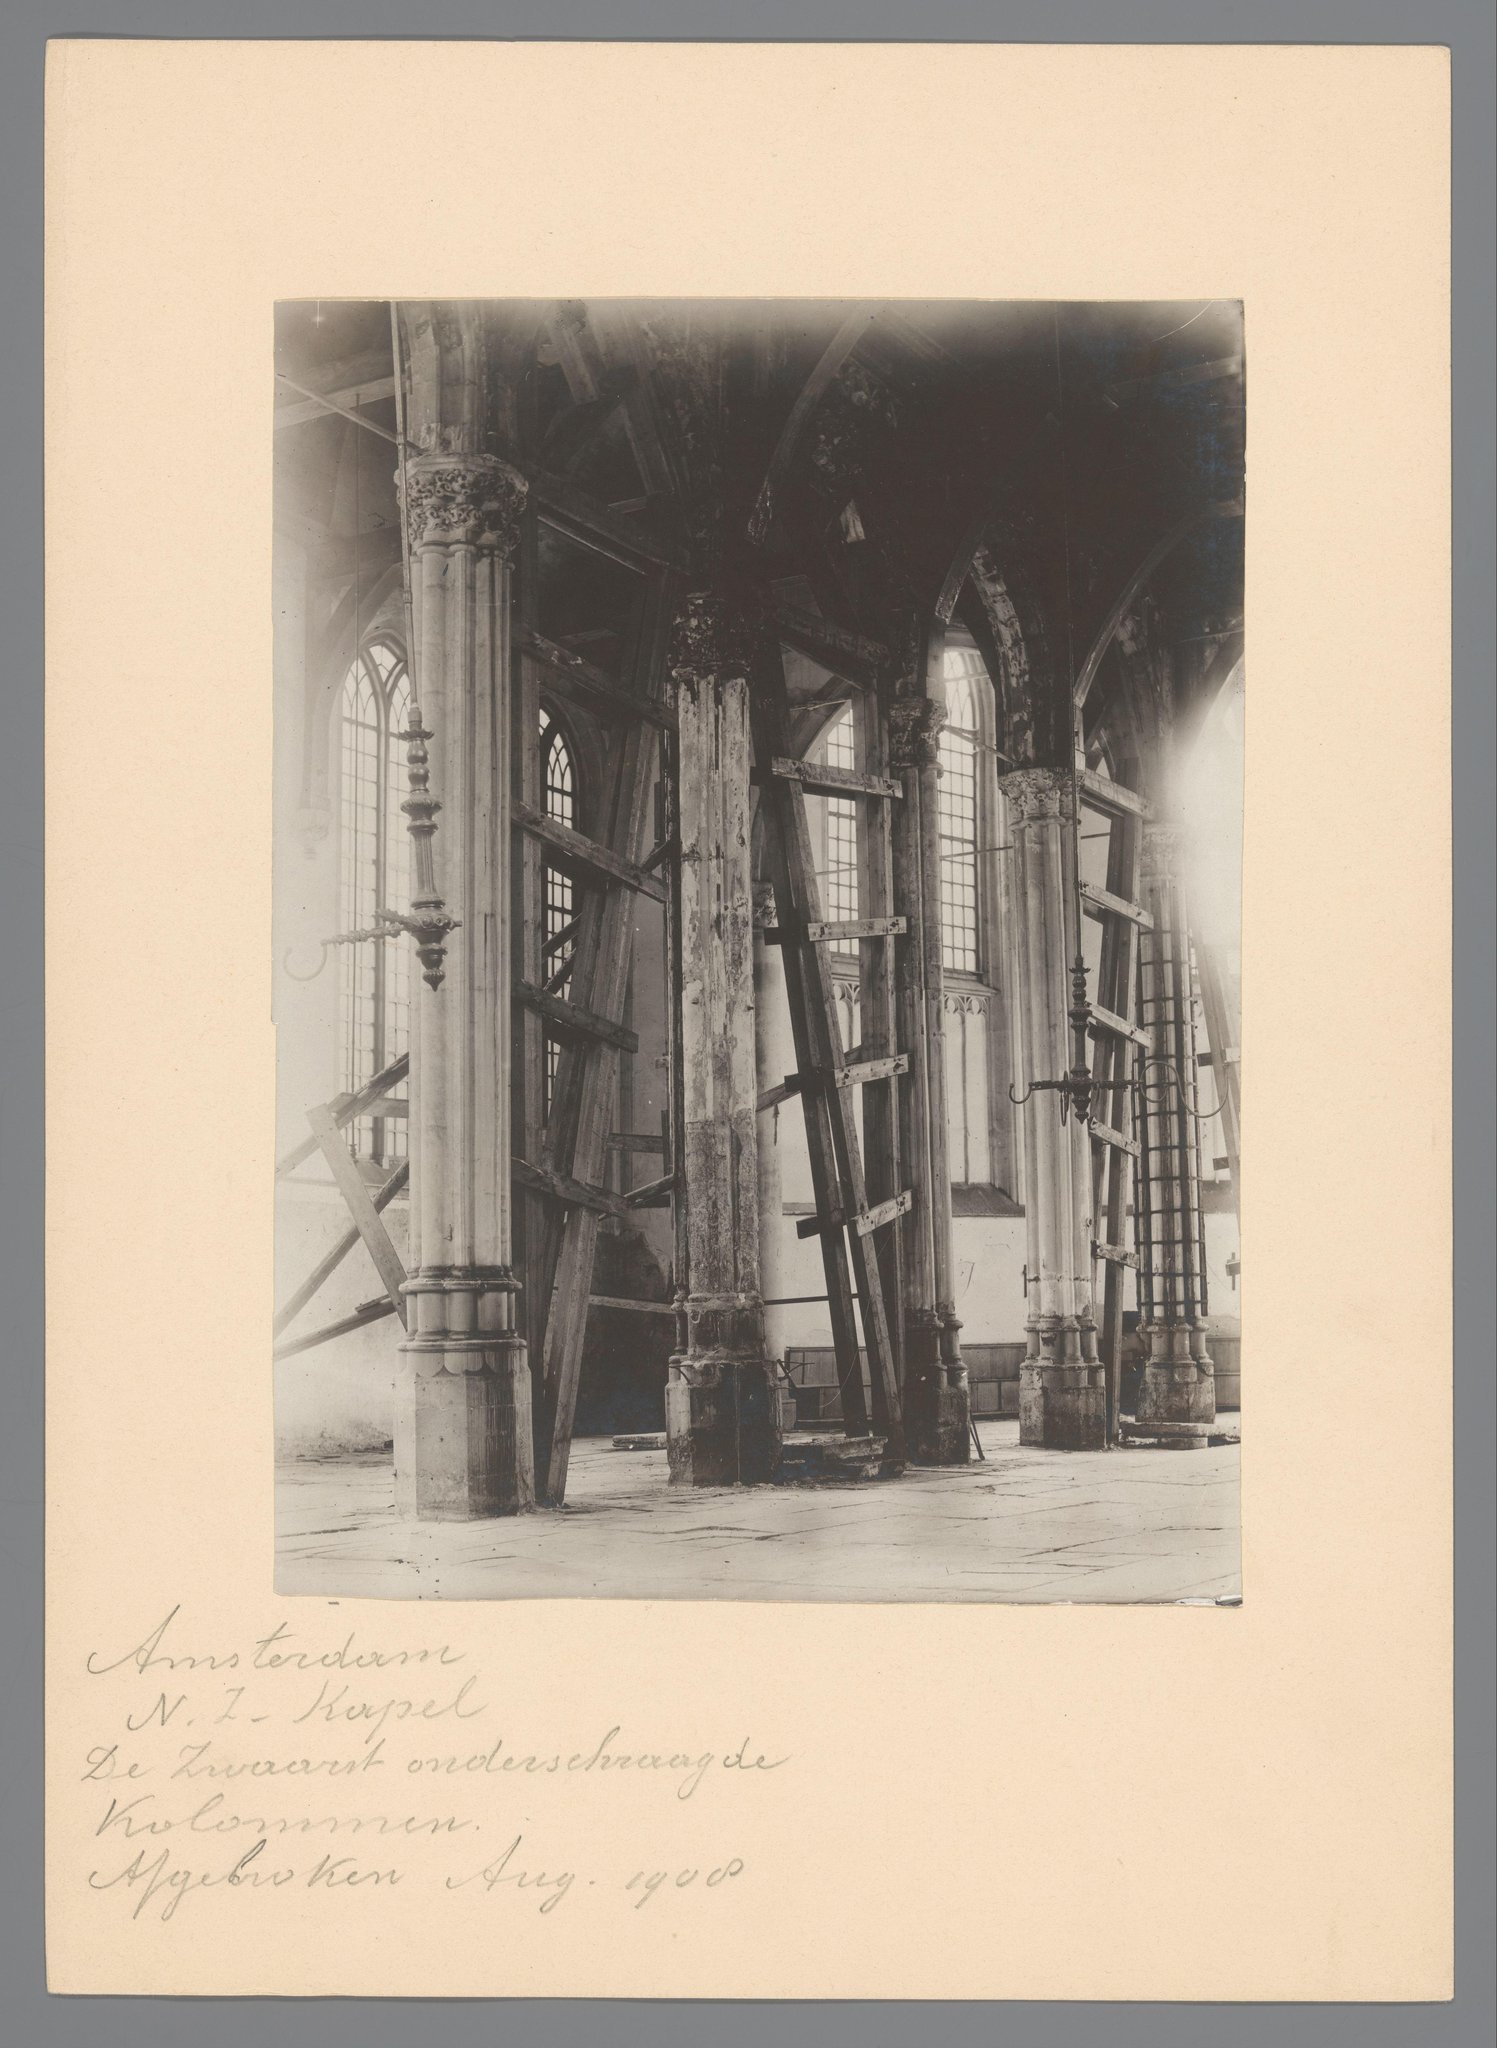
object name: photograph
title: Interieur van de Nieuwezijds Kapel te Amsterdam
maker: albert adriaansz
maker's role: fotograaf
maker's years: 1877-1941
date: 1908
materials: cardboard, photographic support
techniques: gelatin silver print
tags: interior of church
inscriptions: annotation: ‘Amsterdam/ N.Z. Kapel/ De zwaarst onderschraagde/ kolommen/ afgebroken Aug. 1908’